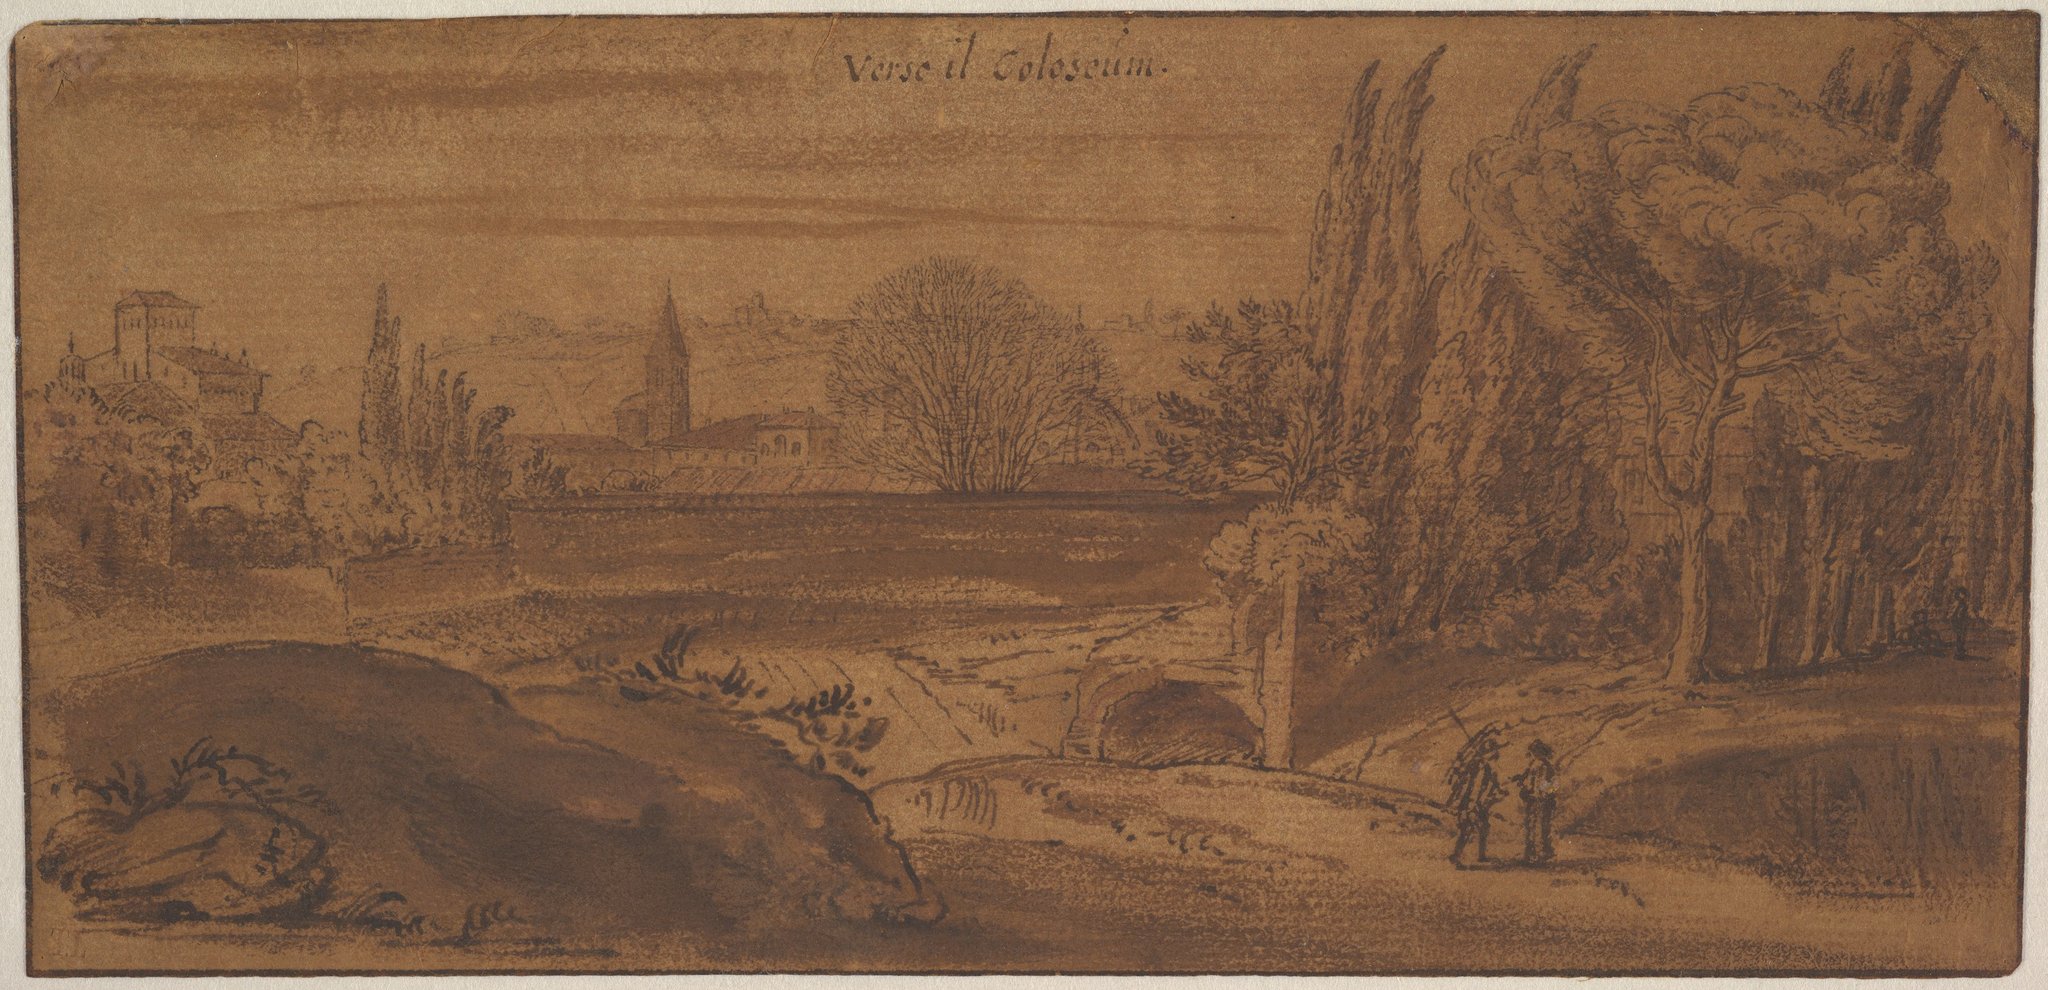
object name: drawing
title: View in Rome near the Colosseum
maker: michiel van overbeek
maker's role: artist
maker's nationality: dutch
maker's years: 1663-1709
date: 1634-1733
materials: ink, paper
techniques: pen, wash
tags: human figures,cities,landscapes,trees